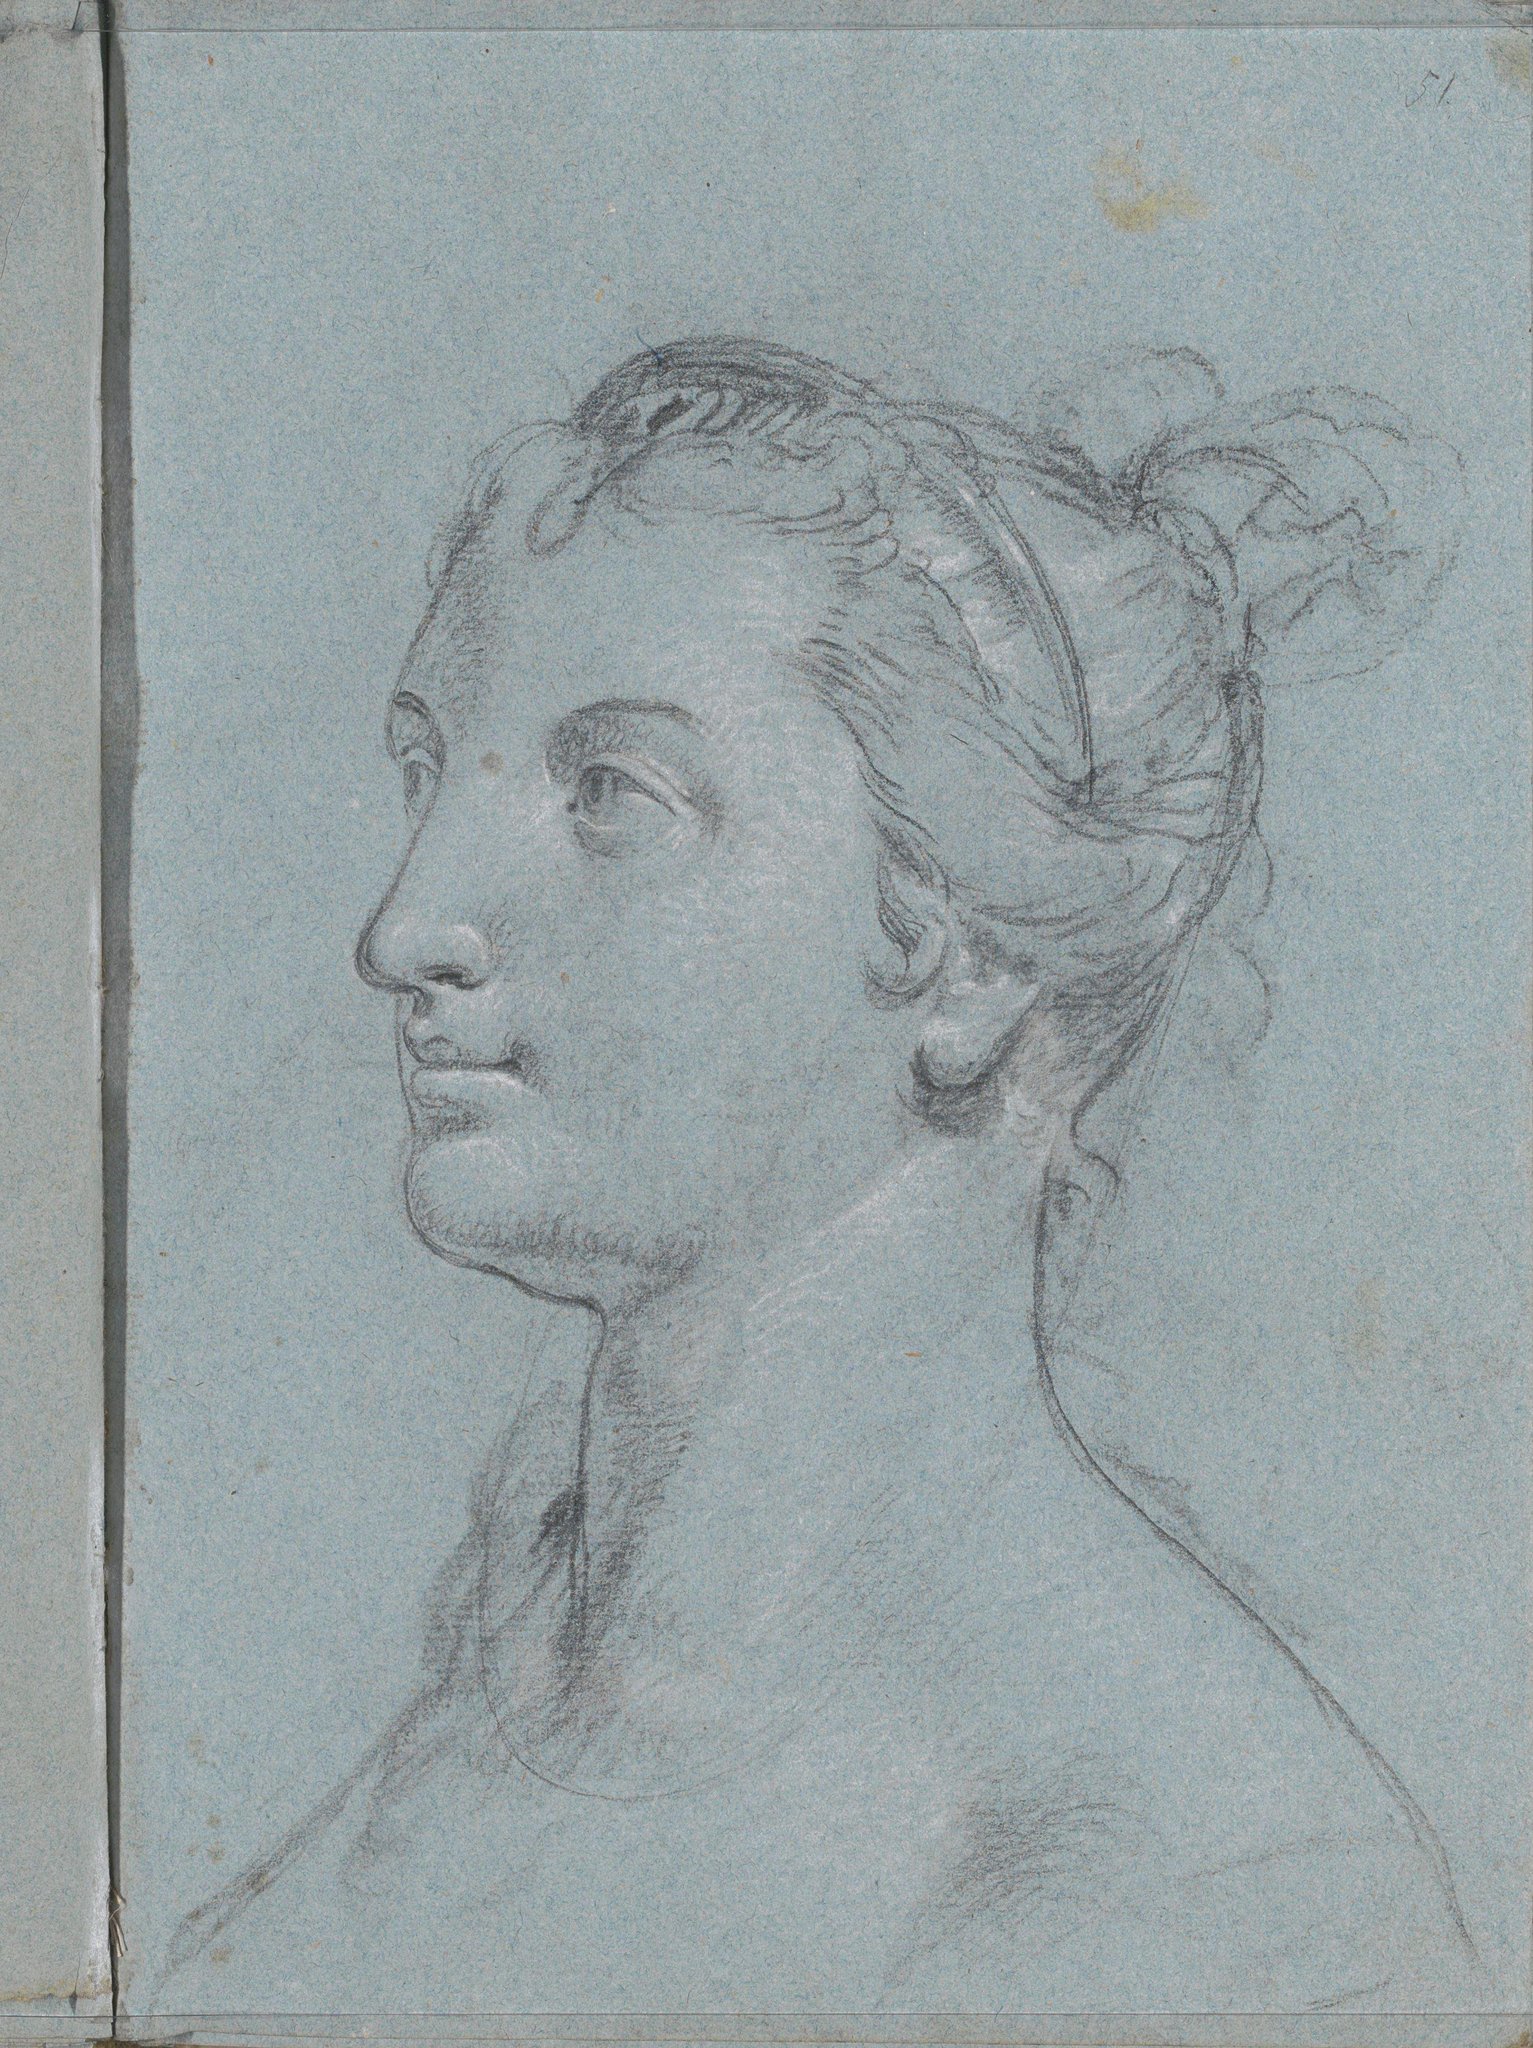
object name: sketchbook leaf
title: Kop van een vrouw met opgestoken haar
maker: lorenzo baldissera tiepolo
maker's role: draughtsman, print maker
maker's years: 1736-1776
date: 1751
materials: chalk, paper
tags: head (human) - aa - female human figure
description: Bladzijde 51 uit een schetsboek met 158 bladzijden.